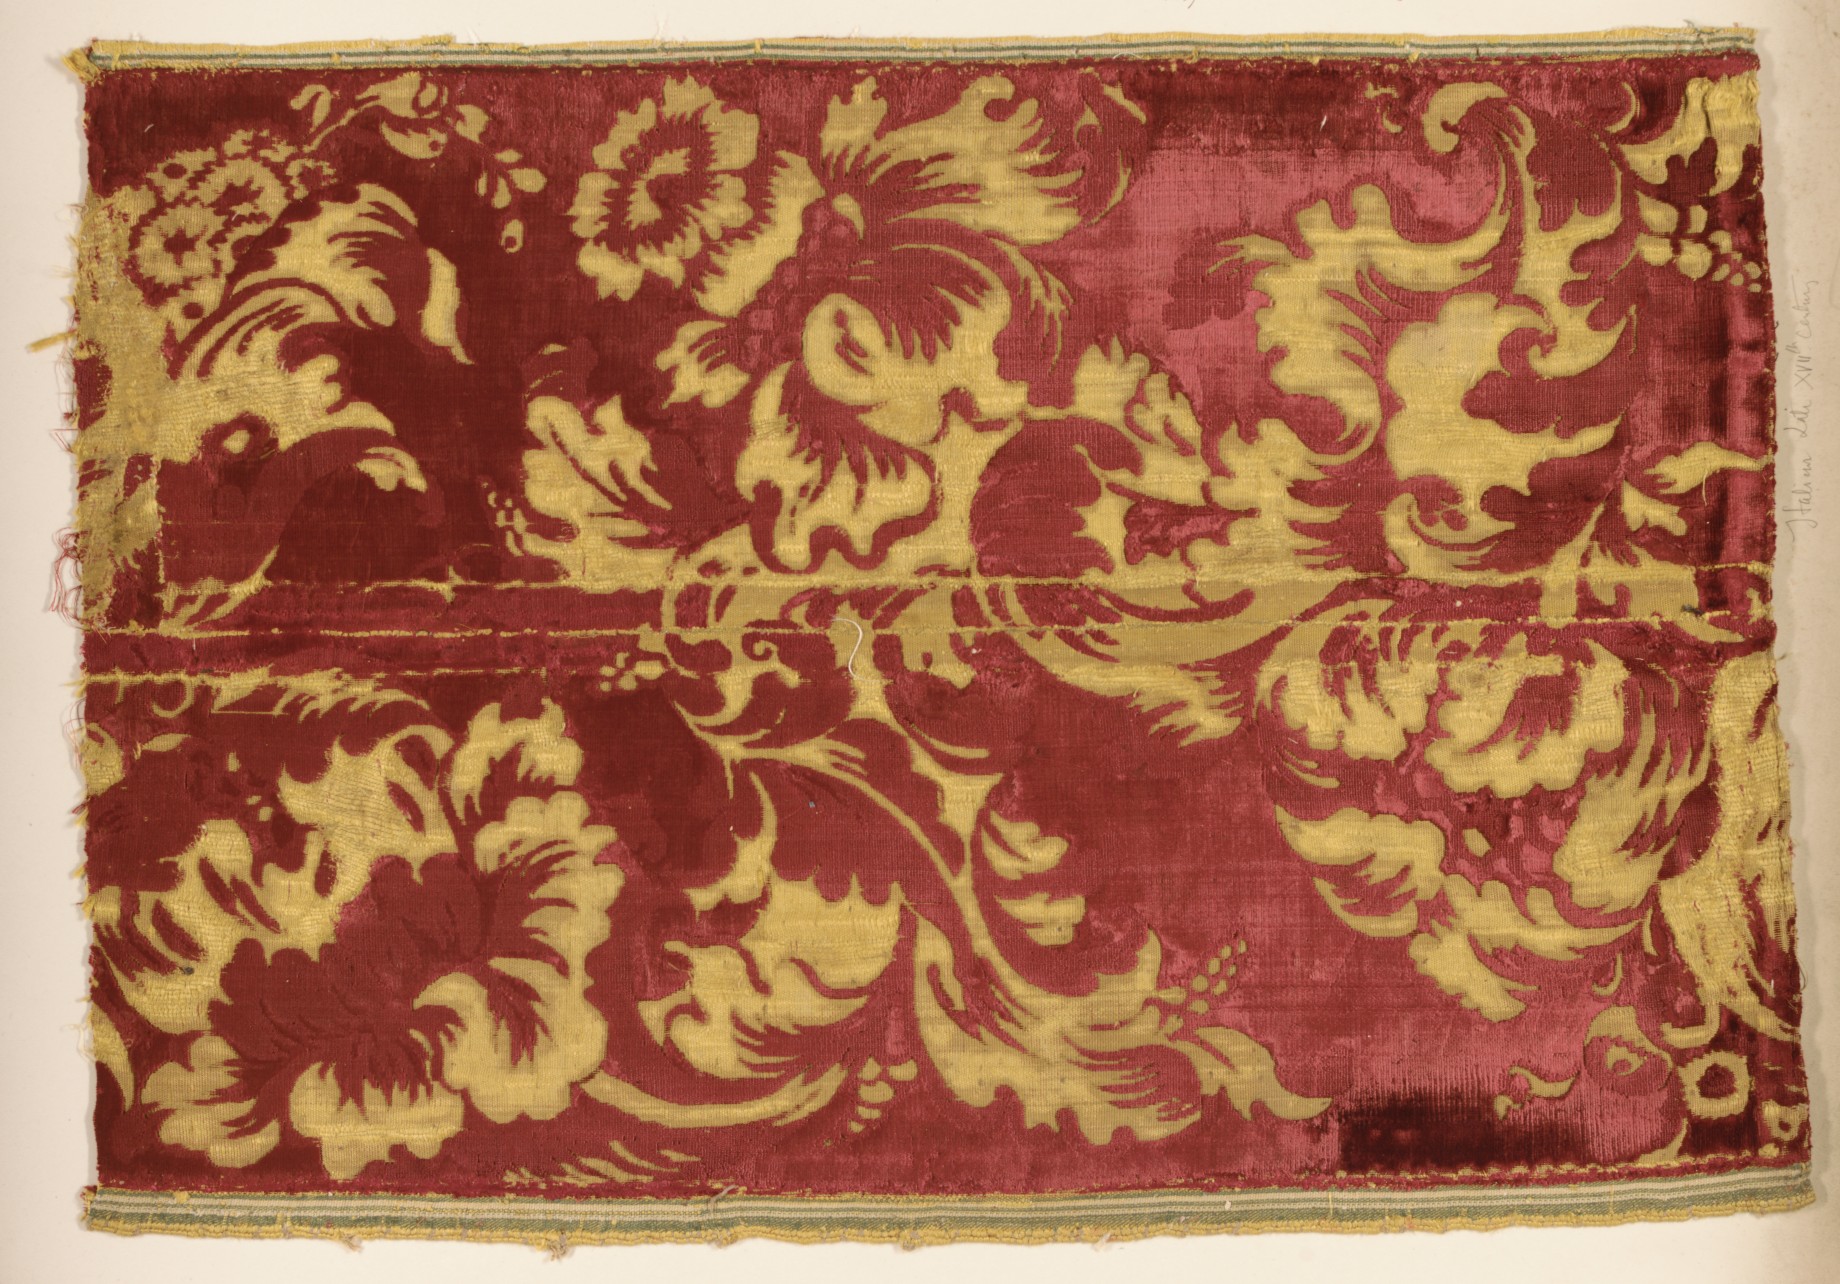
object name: fragment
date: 1667-1700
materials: silk